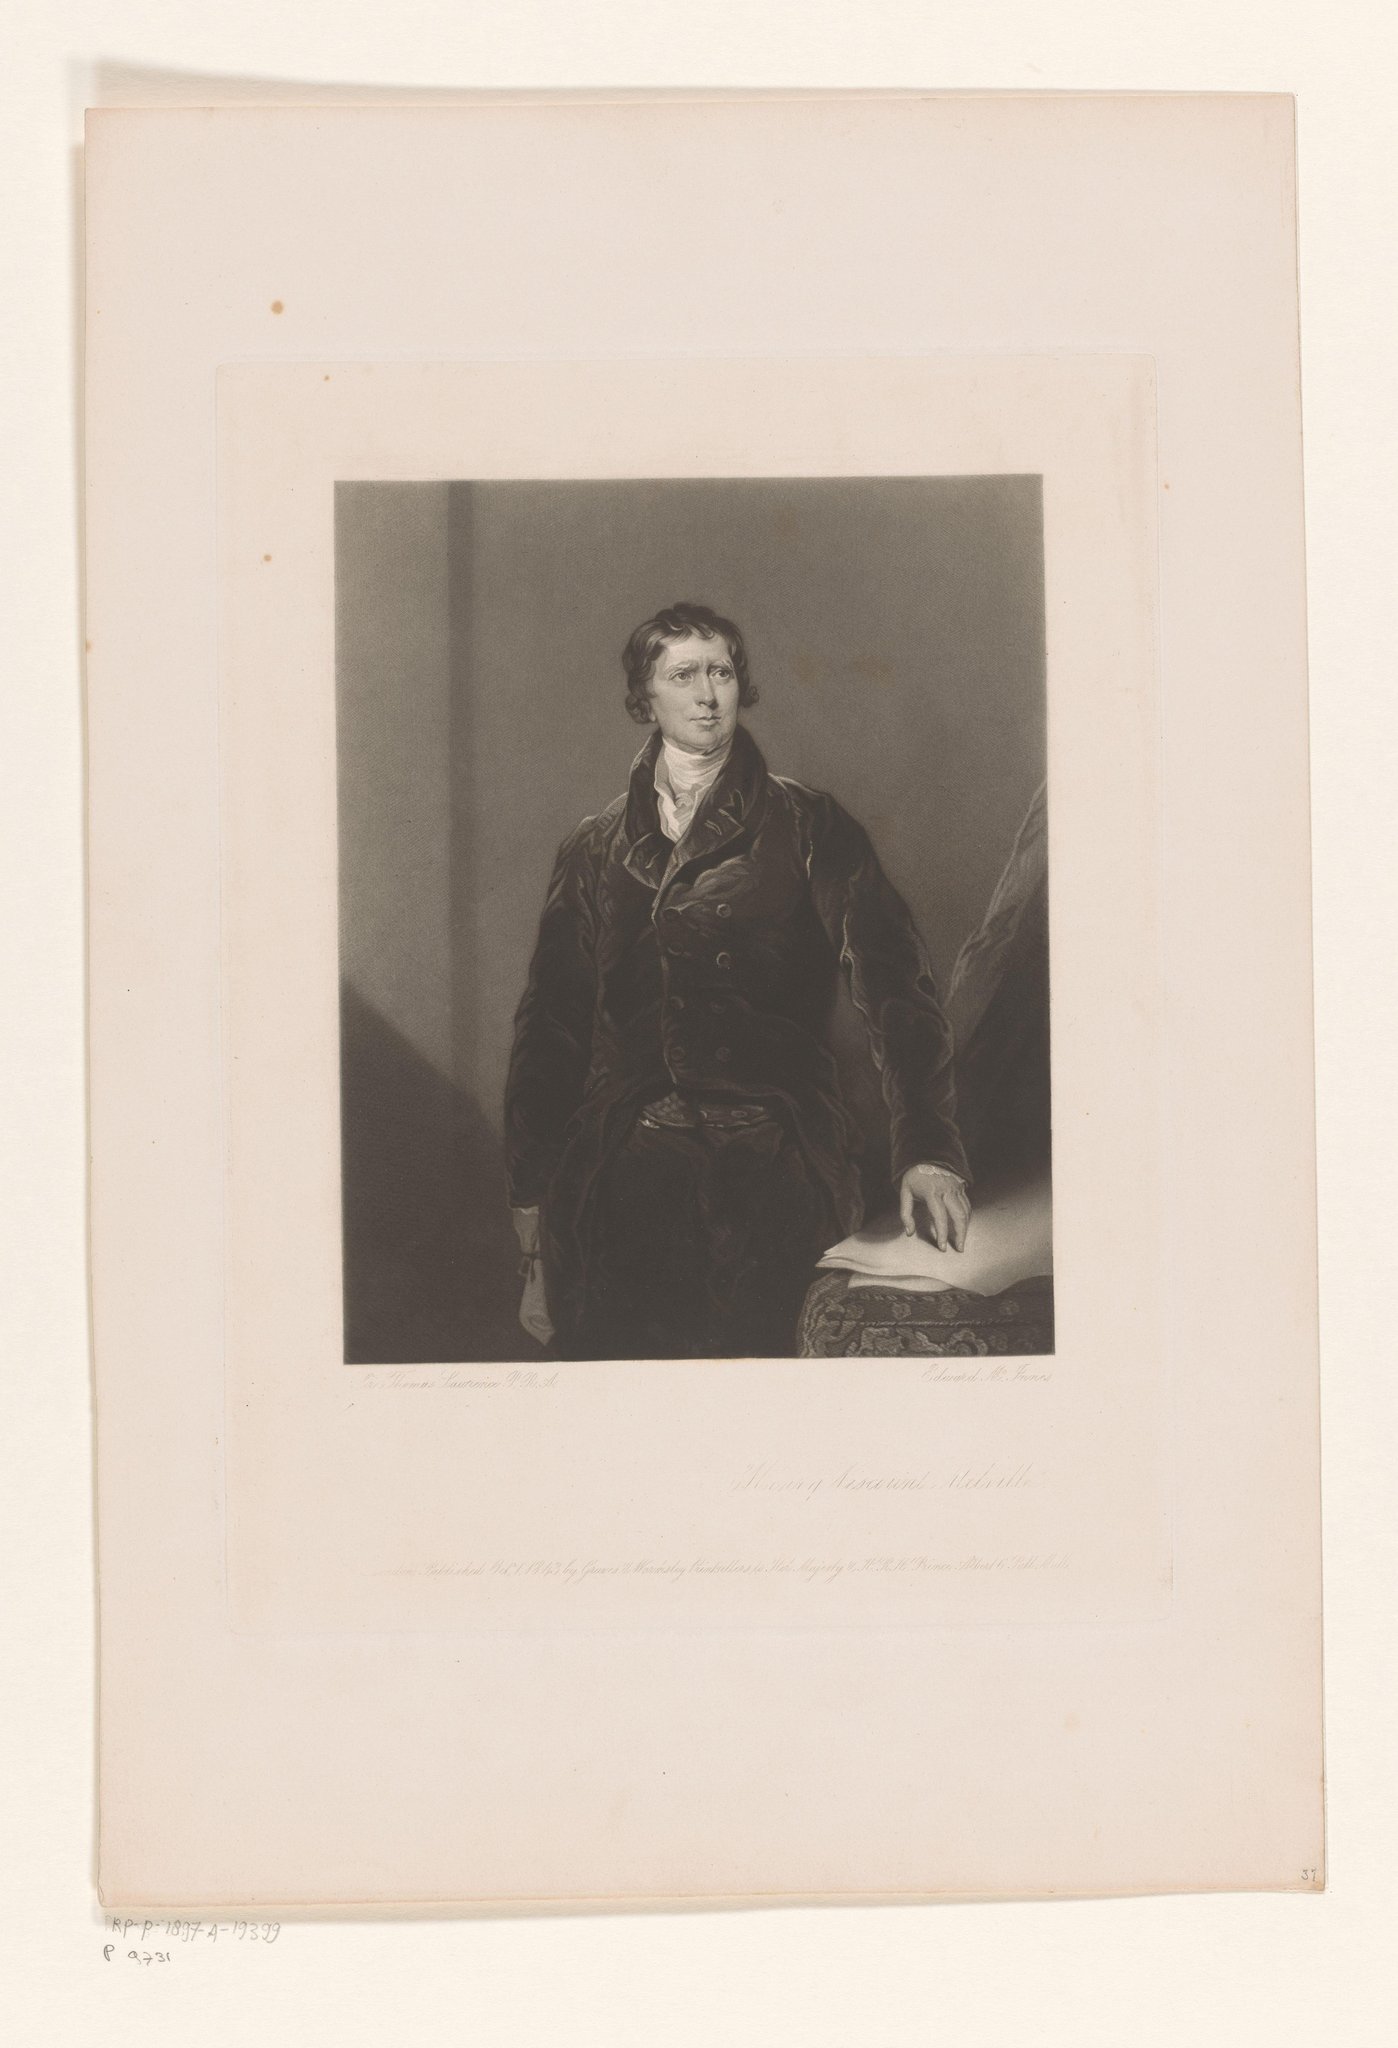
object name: print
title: Portret van Henry Dundas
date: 1842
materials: paper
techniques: mezzotint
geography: london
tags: historical persons, politician, e.g. party leader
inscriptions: collector's mark: Lugt 2228